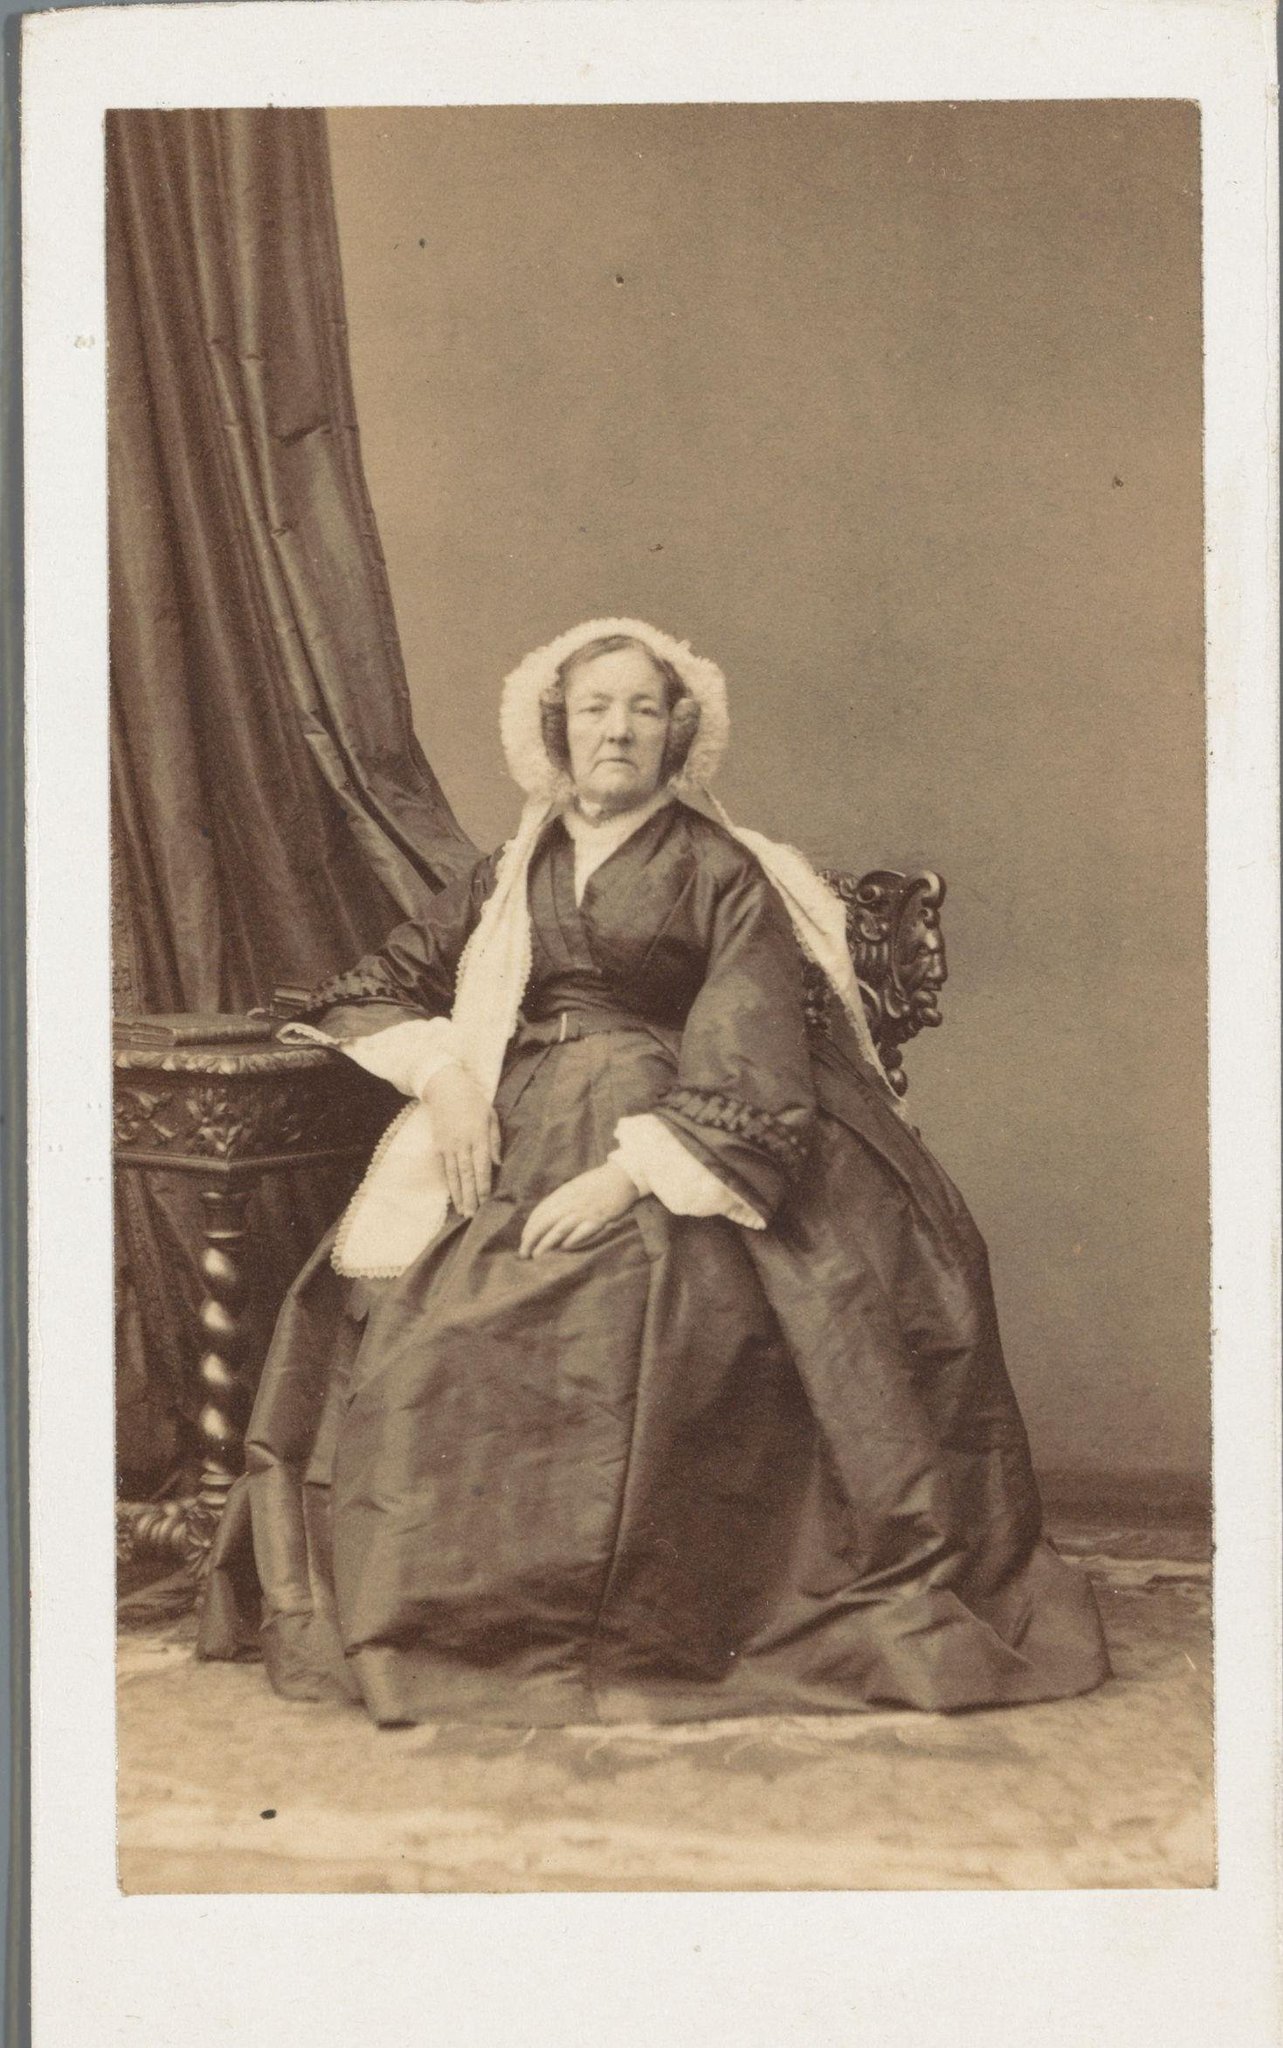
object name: carte de visite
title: Cartes-de-visite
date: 1854-1889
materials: cardboard, paper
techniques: albumen print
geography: paris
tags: sitting figure, historical persons - bb - woman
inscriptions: stamp: ‘DISDERI & Cie/ PHOTOGRAPHES de S.M. L'EMPEREUR/ 8, Boulevart des Italiens, PARIS.’, inscription: ‘15’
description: Cartomanie was a collecting craze. From 1855 hundreds of thousands of these portraits were annually sold worldwide. People had photographs taken of their loved ones, including their pets, and kept them in an album. Portraits of kings, writers, artists, actors, and statesmen were also collected. Photography was no longer the preserve of the wealthy; farmers and maidservants now also stood before the camera.